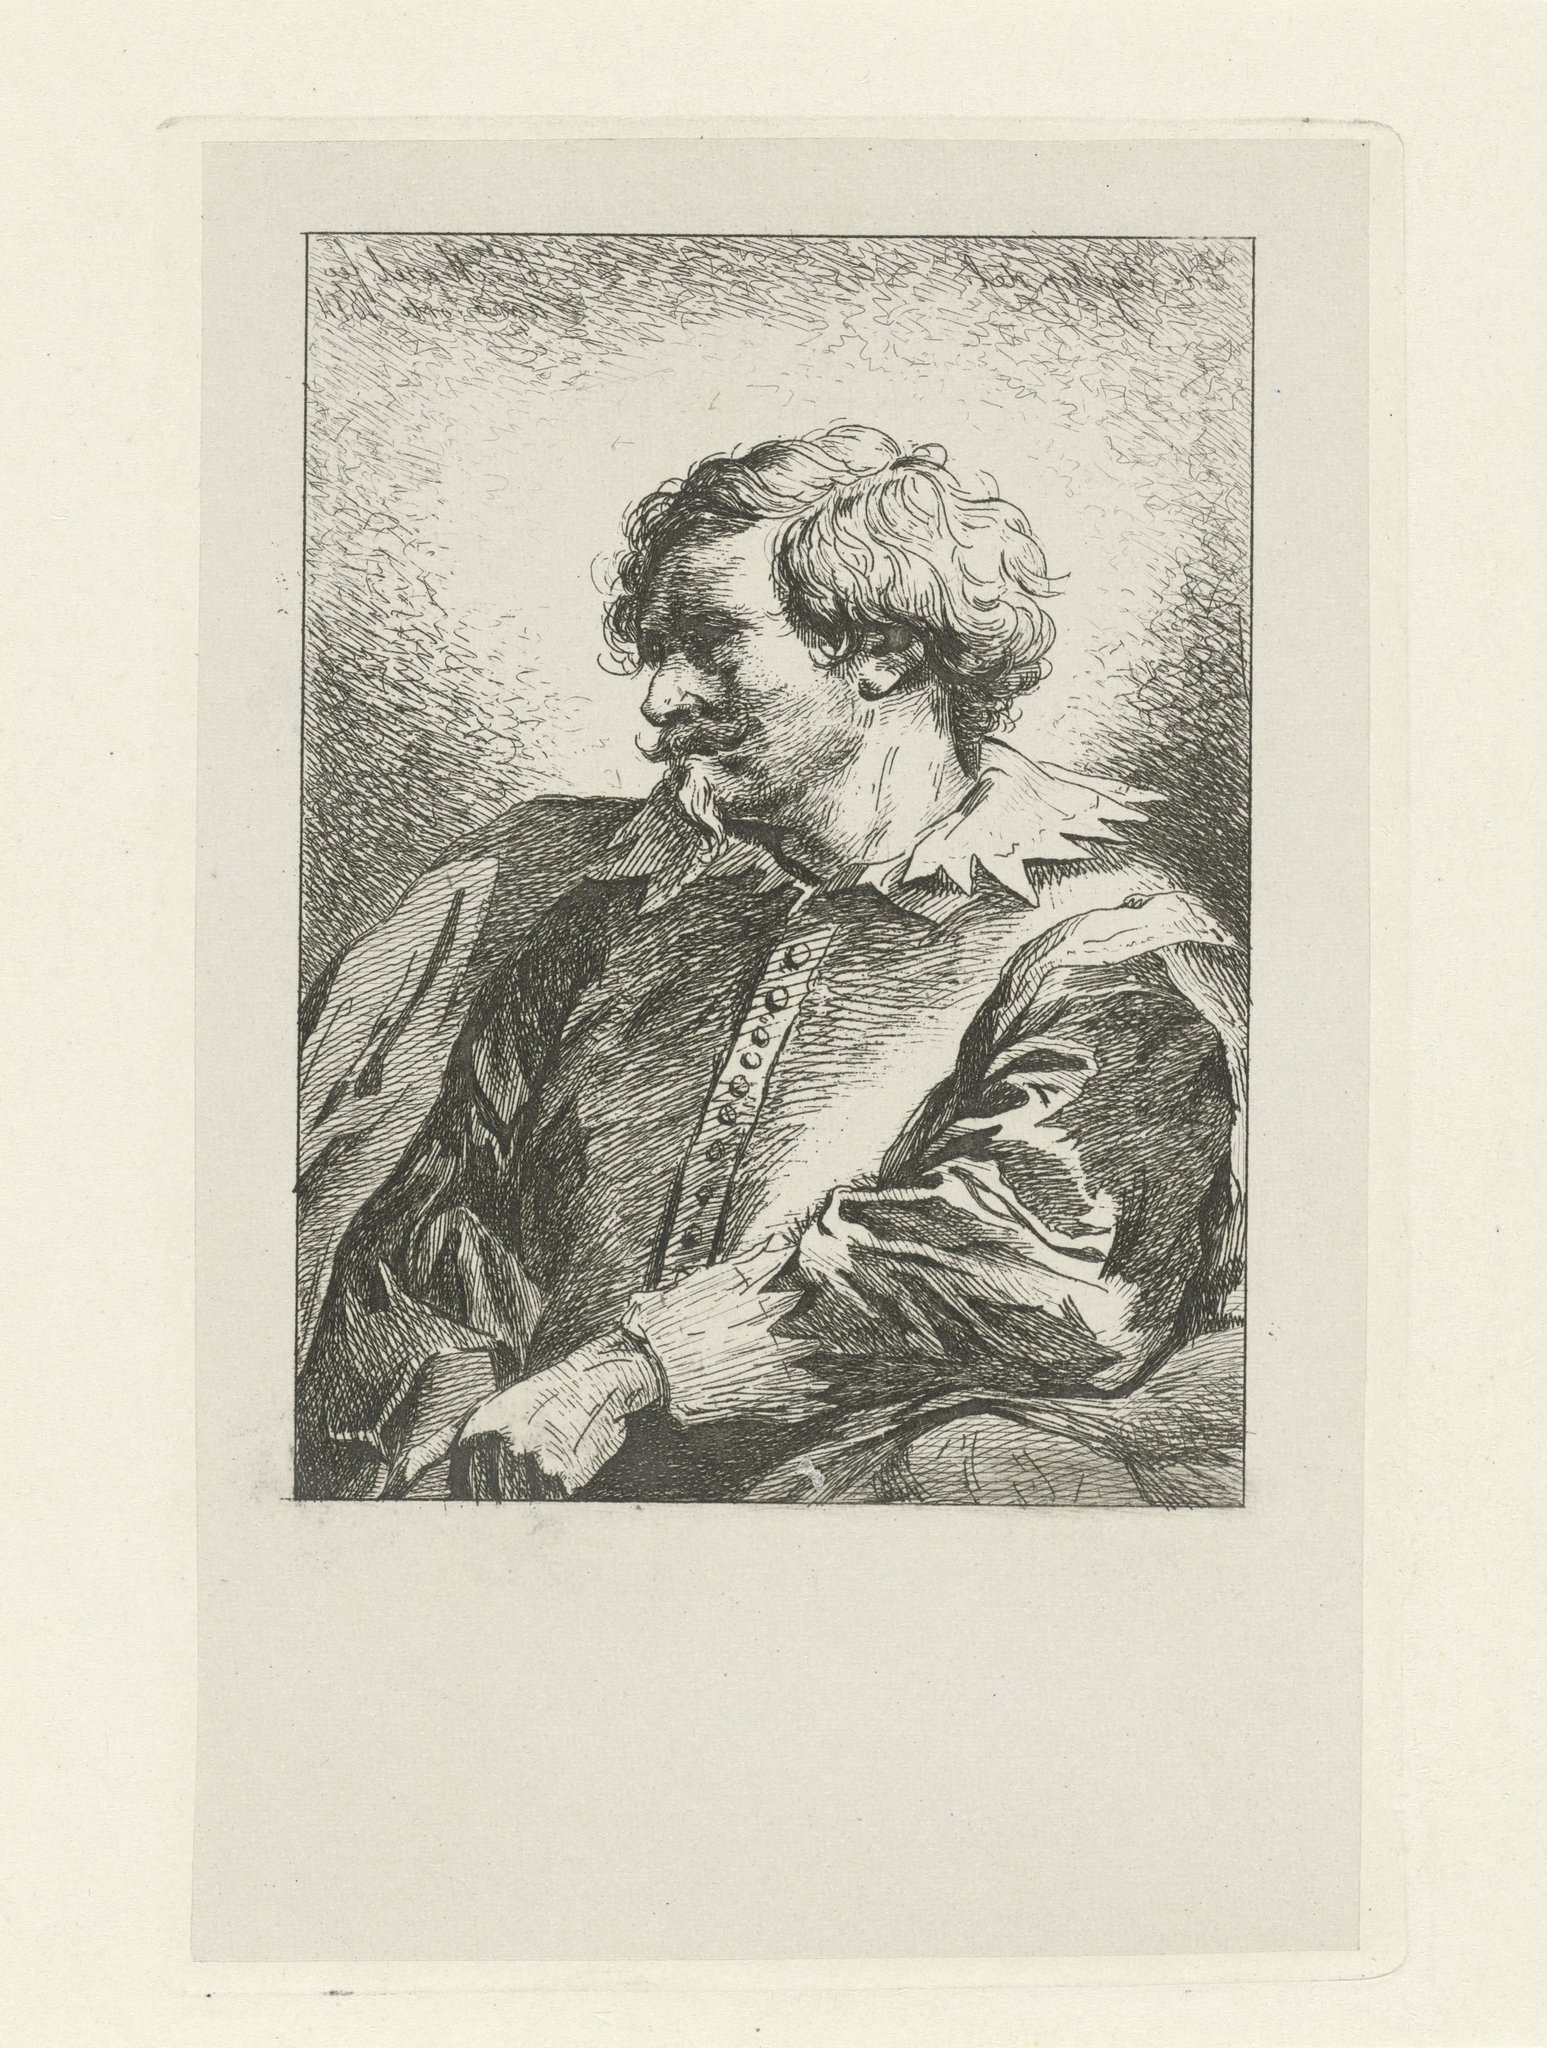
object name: print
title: Portret van een man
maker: jean zacherie mazel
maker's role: draughtsman, print maker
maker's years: 1792-1884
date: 1802-1884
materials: paper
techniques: etching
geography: netherlands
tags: adult man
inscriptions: collector's mark: Lugt 2233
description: Portret van een man in een kostuum met kraag. Onderaan in de marge de opdracht met een wapenschild, met een leeuw, op de wolken.